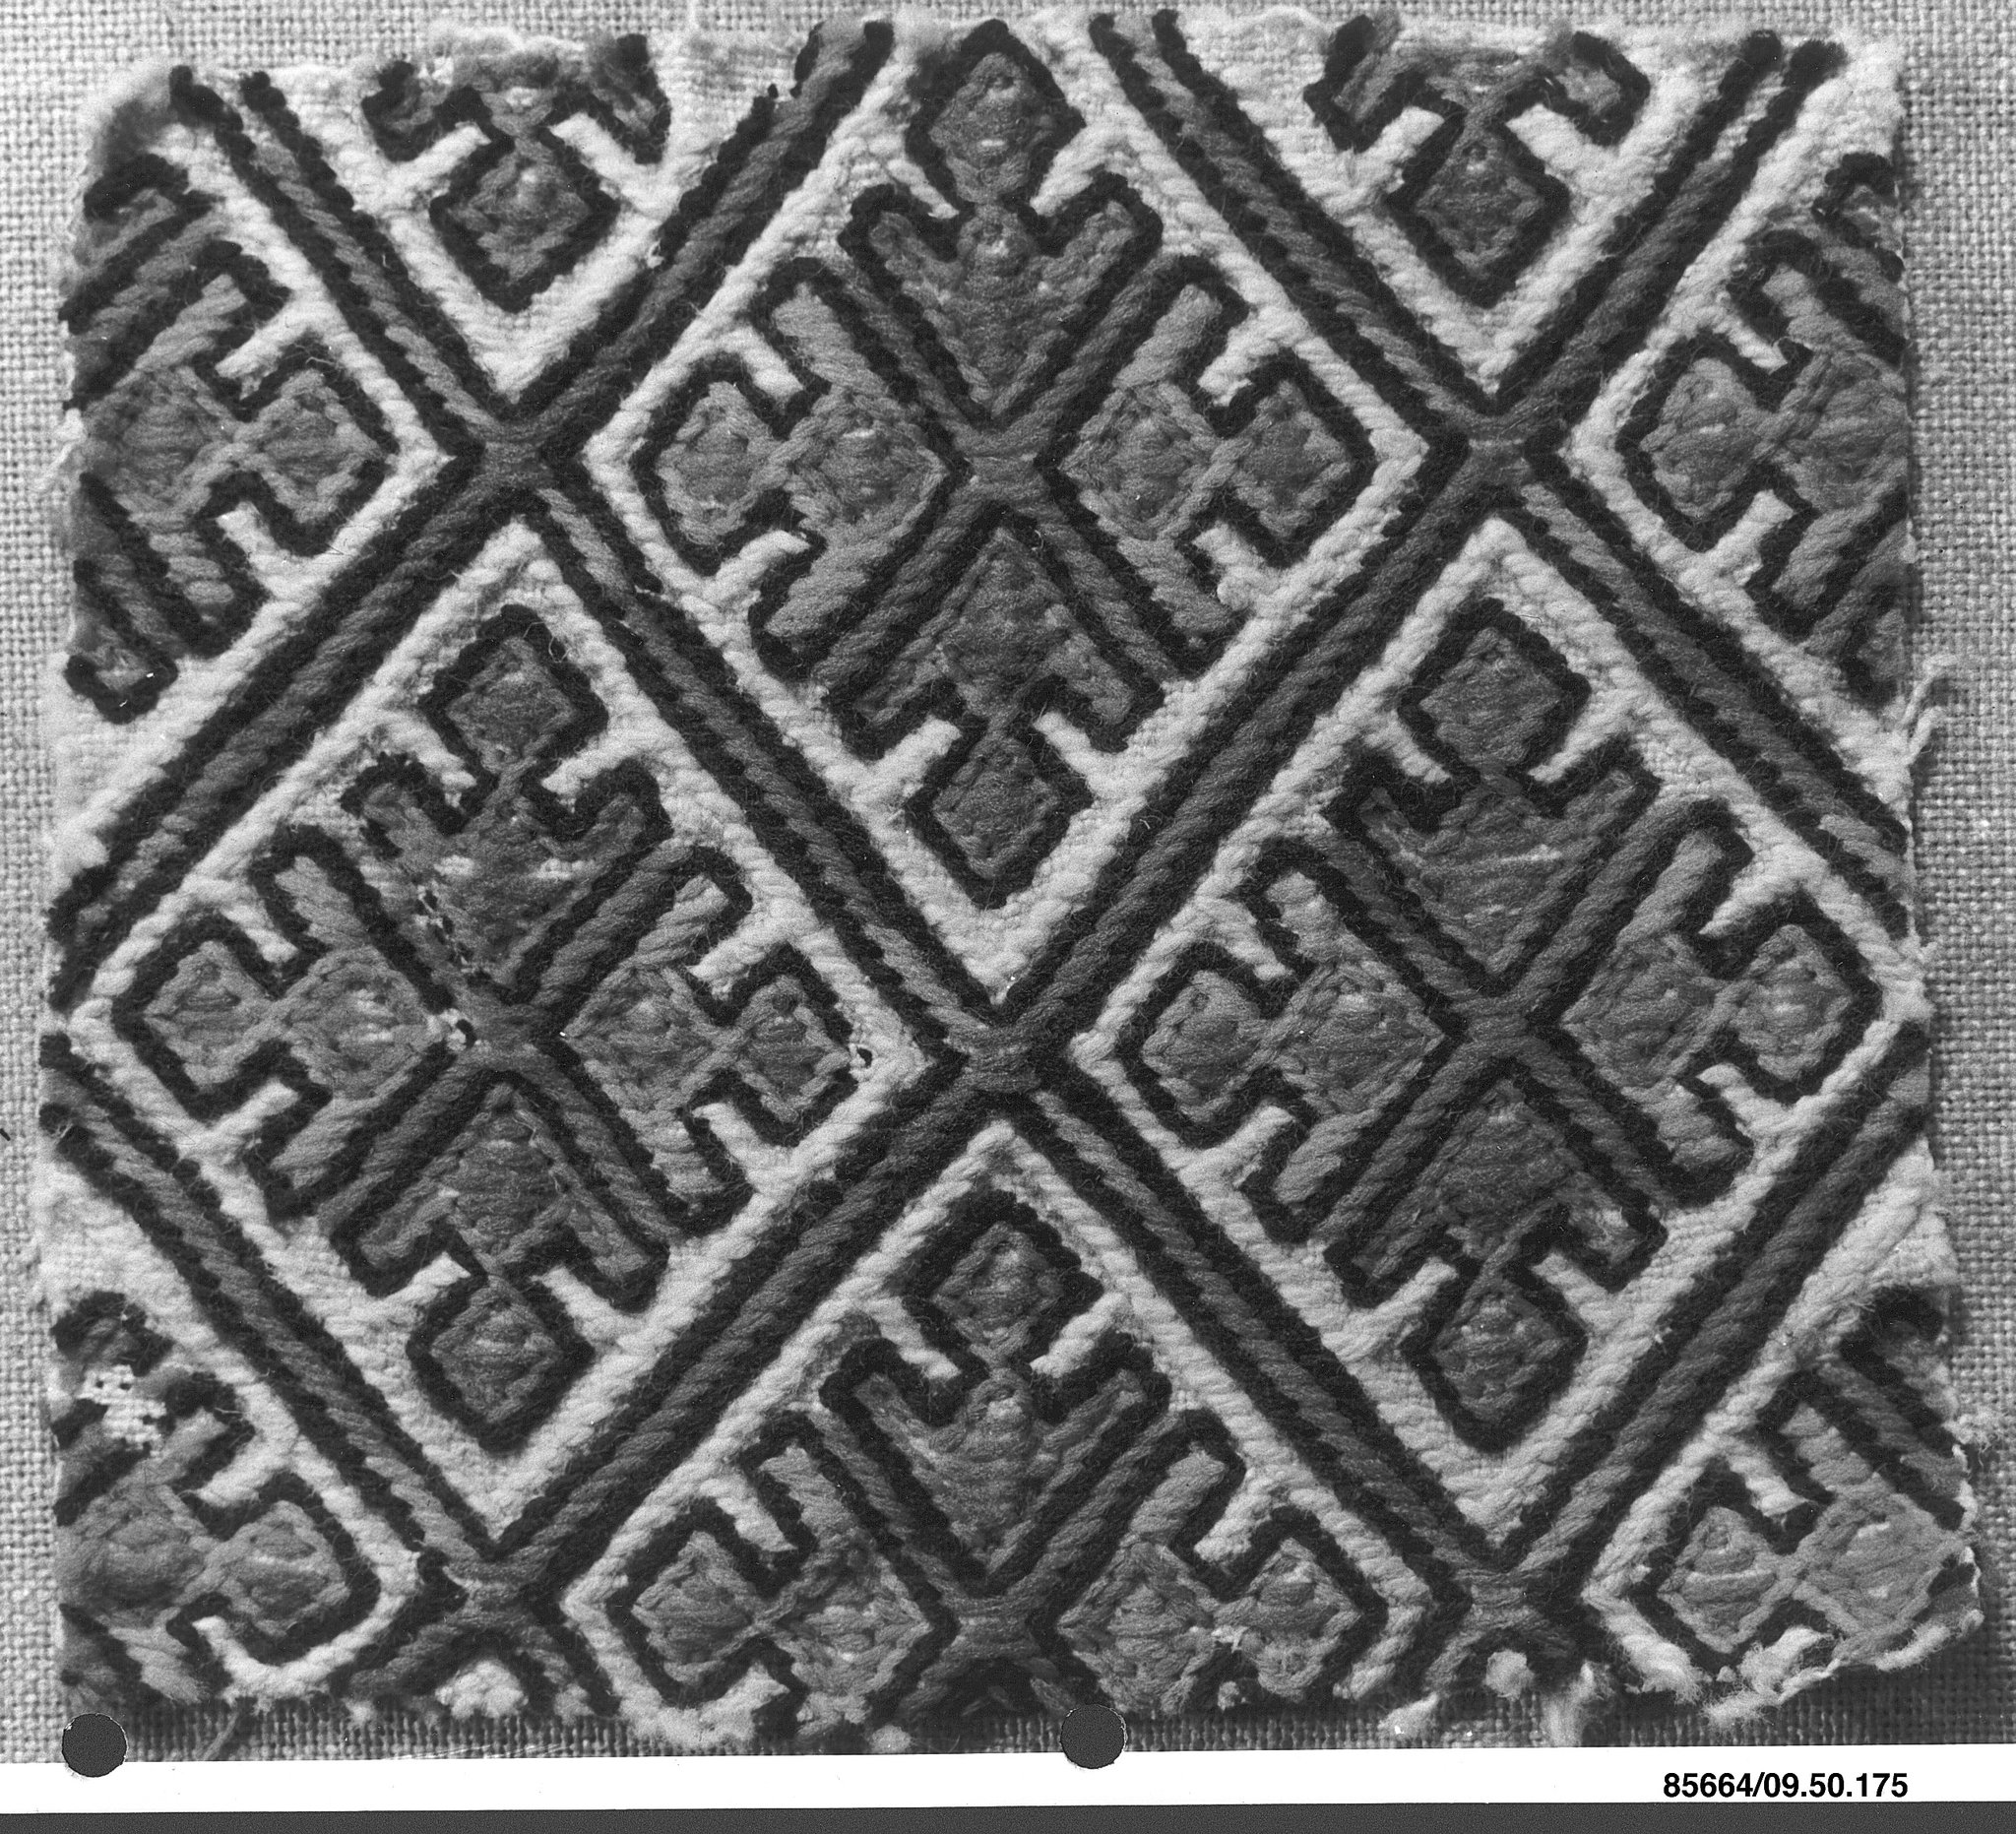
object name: costume fragment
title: Peasant costume fragment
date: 1701-1900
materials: canvas, wool